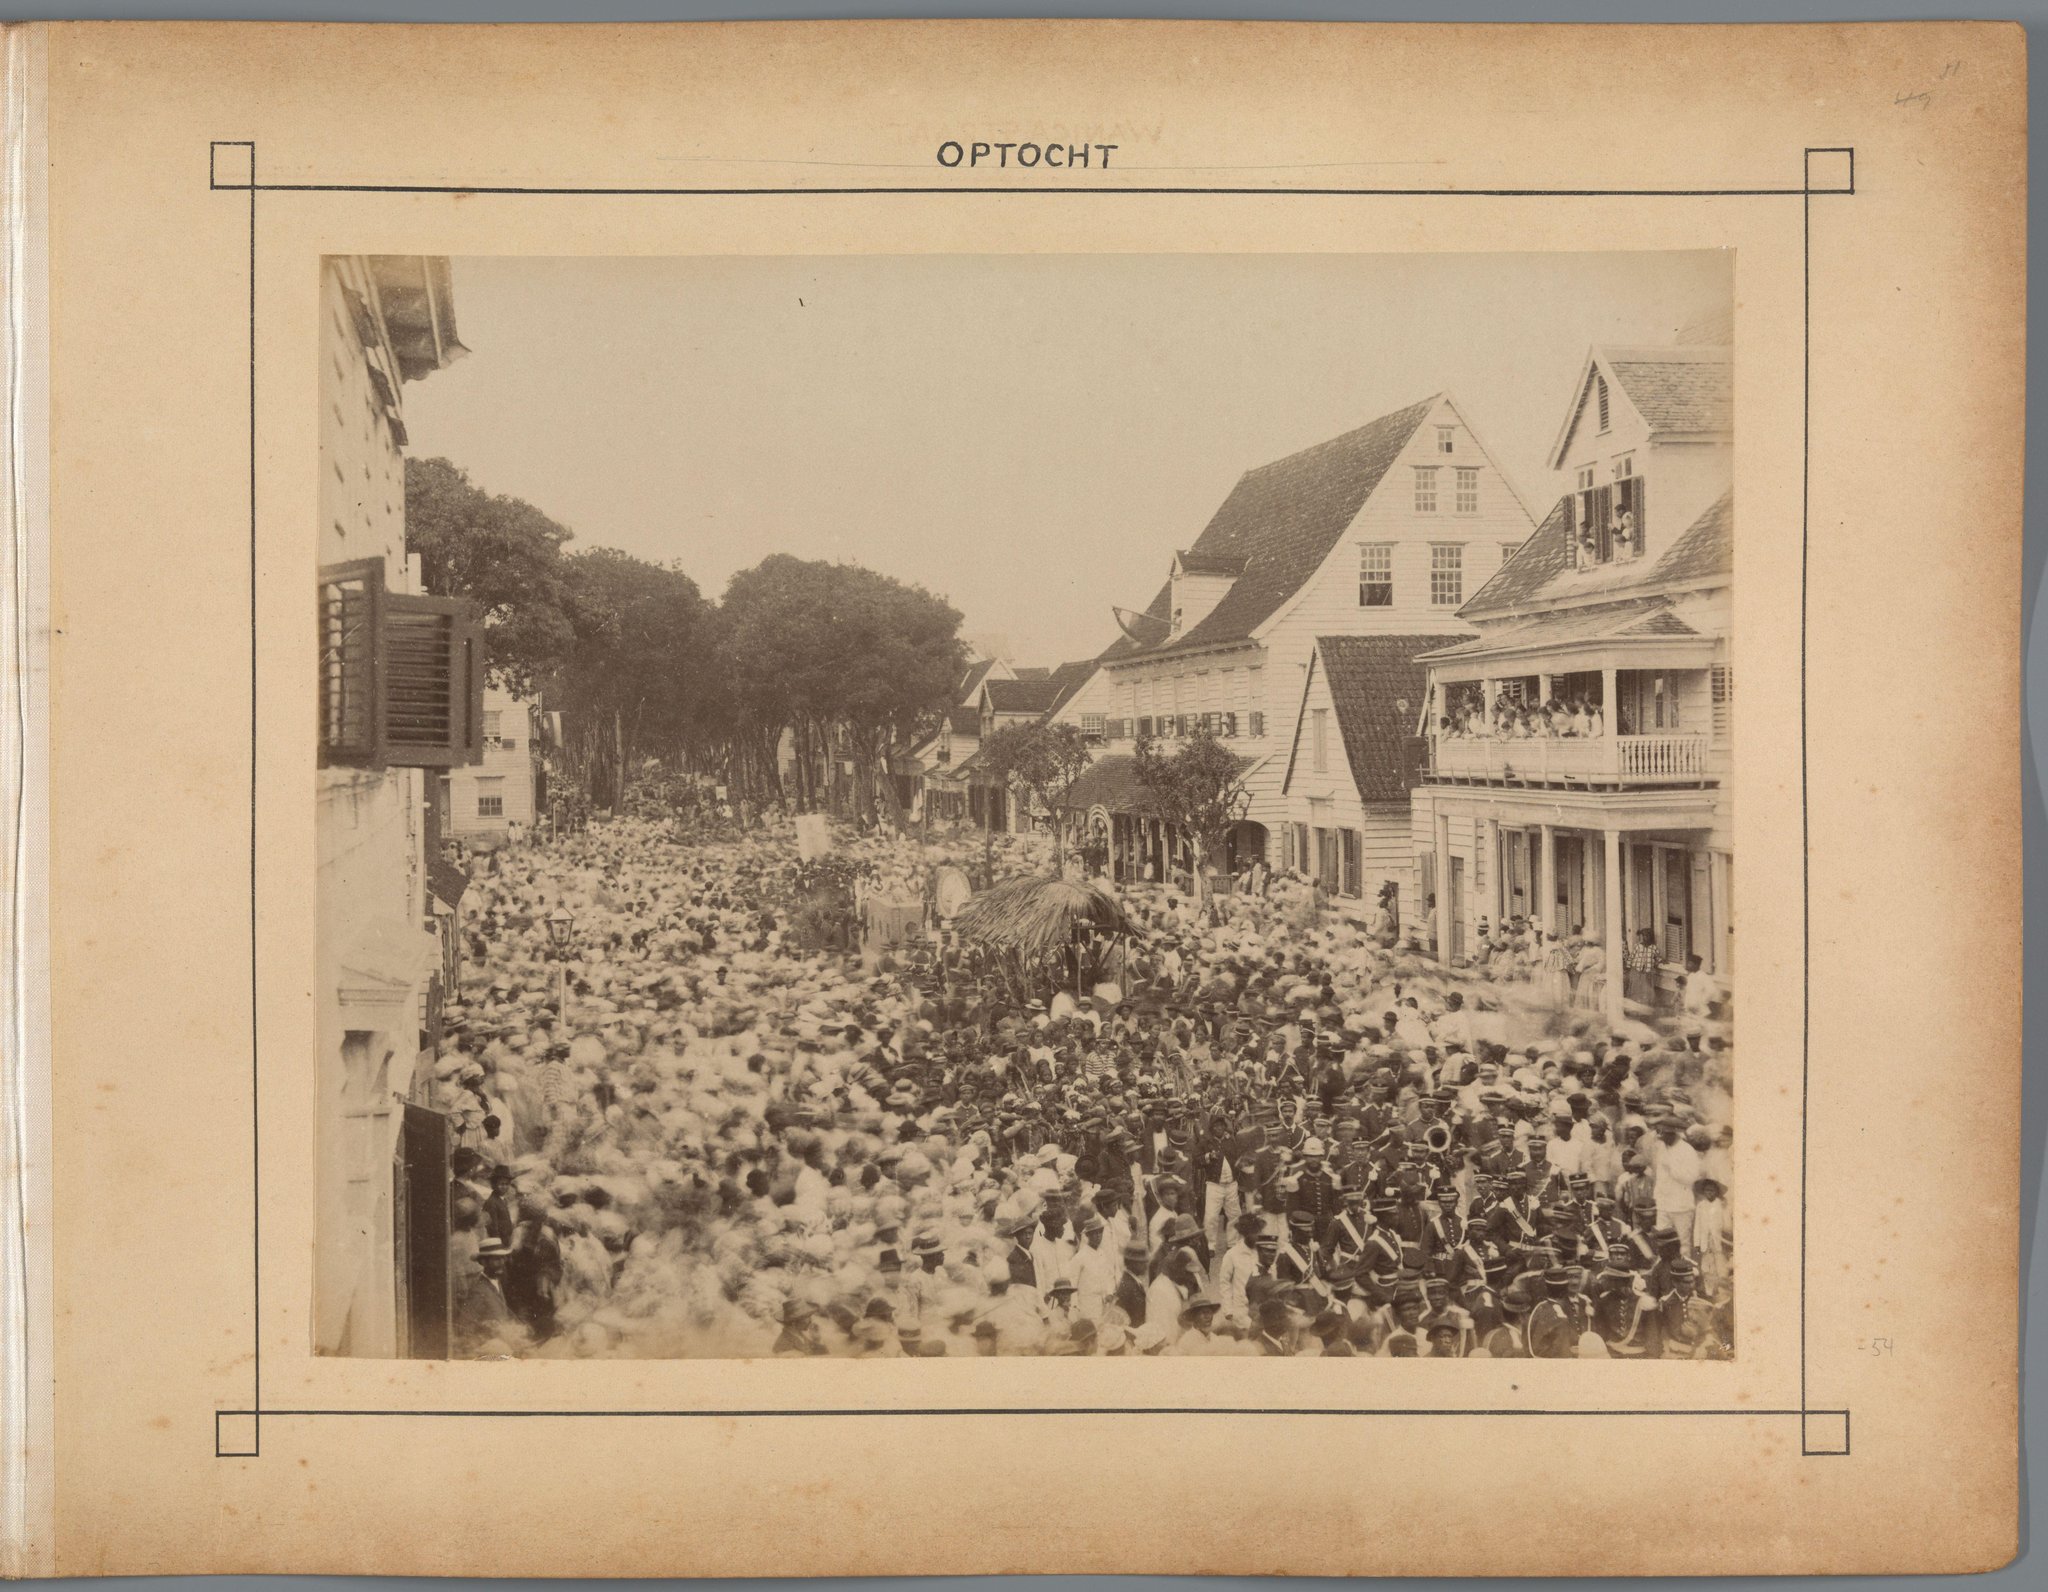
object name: photograph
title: Optocht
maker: julius muller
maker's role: official, politician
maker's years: 1846-1902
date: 1885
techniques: albumen print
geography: suriname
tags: suriname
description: Grote groep mensen op de been in Paramaribo, mogelijk in 1885 bij de ovatie aan de heer Cateau van Rosevelt ter gelegenheid van zijn vijftigjarige ambtsjubileum in Suriname.